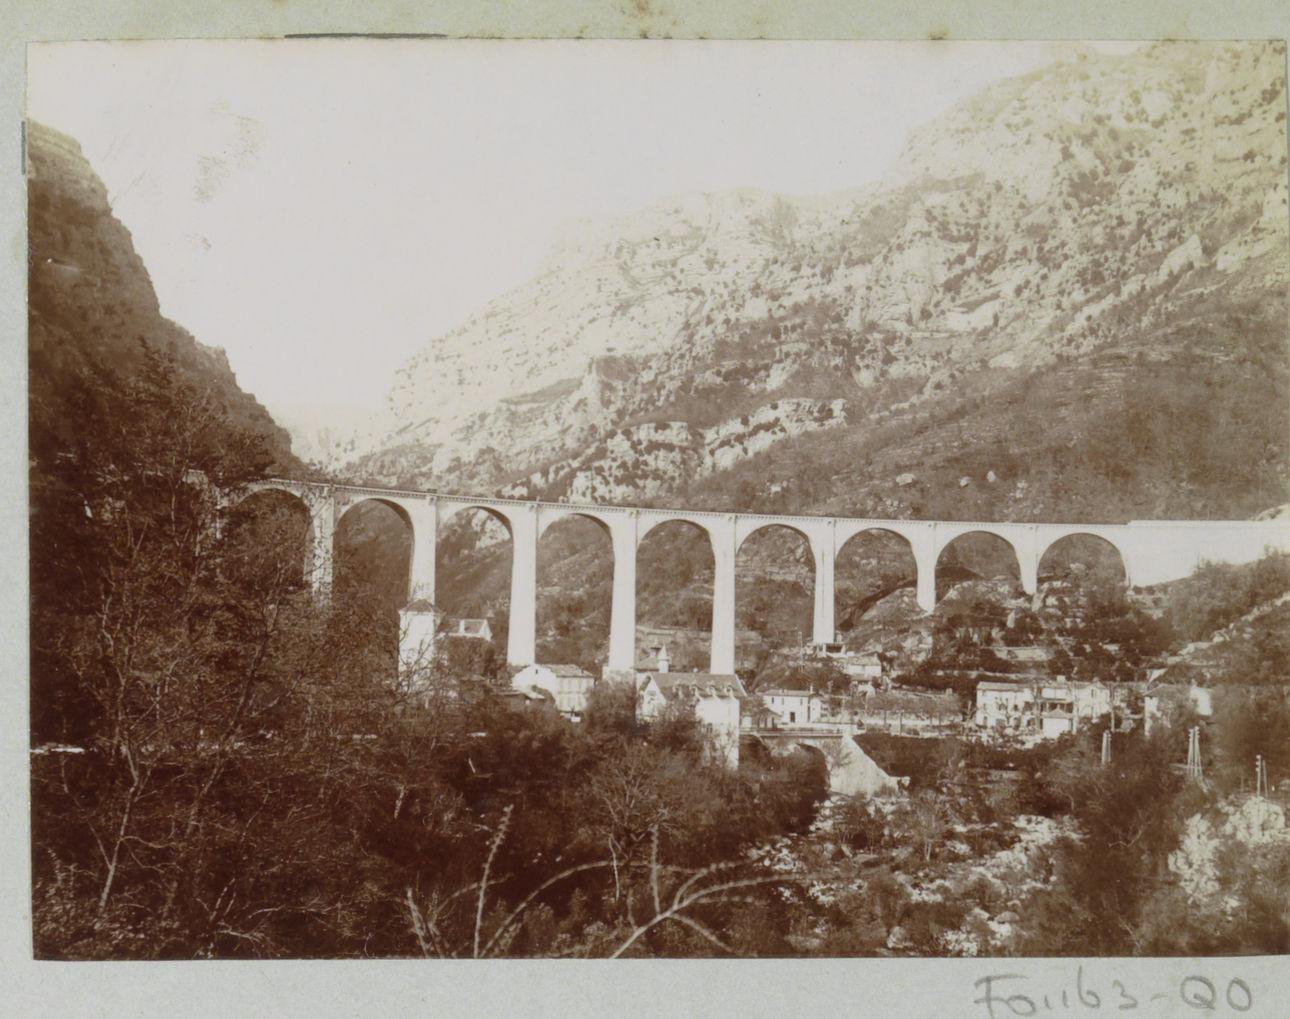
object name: photograph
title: Viaduct bij Pont du Loup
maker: delizy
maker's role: manufacturer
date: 1903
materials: paper, photographic support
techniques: gelatin silver print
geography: pont du loup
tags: prospect of village, silhouette of village, landscape with bridge, viaduct or aqueduct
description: Onderdeel van Fotoalbum van een Franse amateurfotograaf met opnames van uitstapjes in Frankrijk, Spanje, België, Luxemburg en Nederland, de eerste automobielen en autoraces.